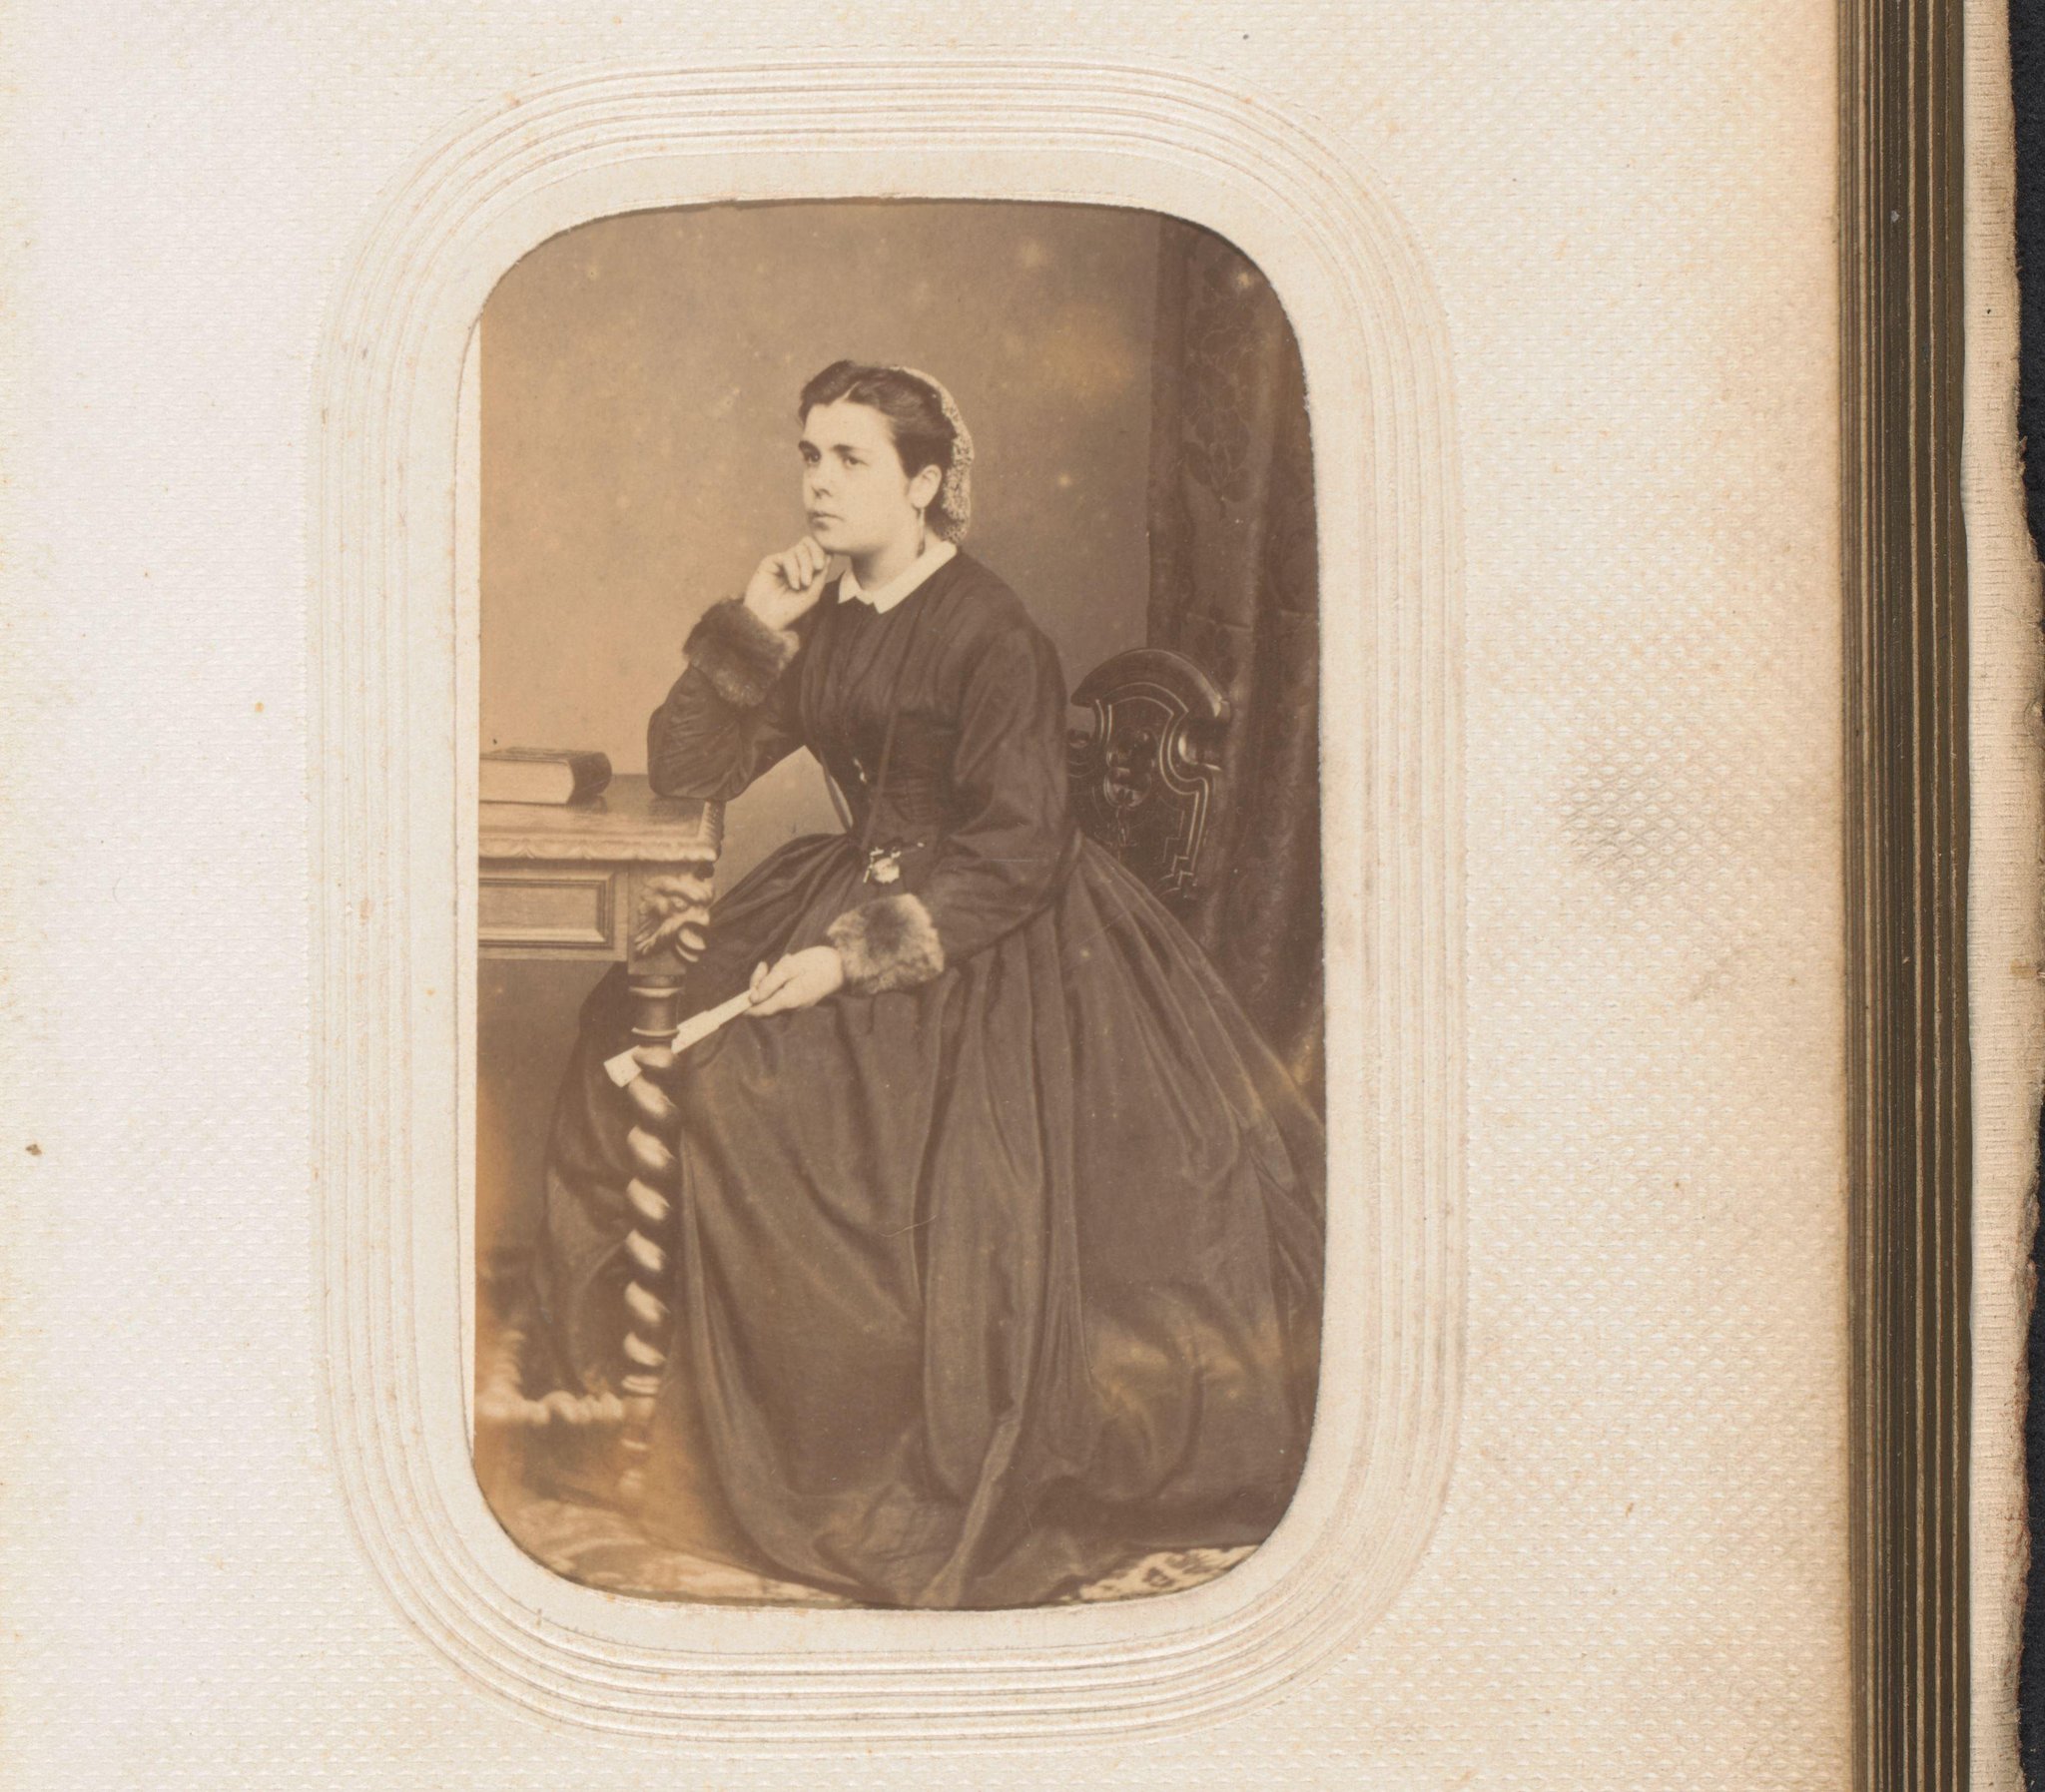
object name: album leaf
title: Portret van een vrouw met waaier, zittend aan tafel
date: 1855-1865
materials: cardboard, photographic support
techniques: albumen print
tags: historical persons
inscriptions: inscription: ‘Rue St Remi 51, Bordeaux’